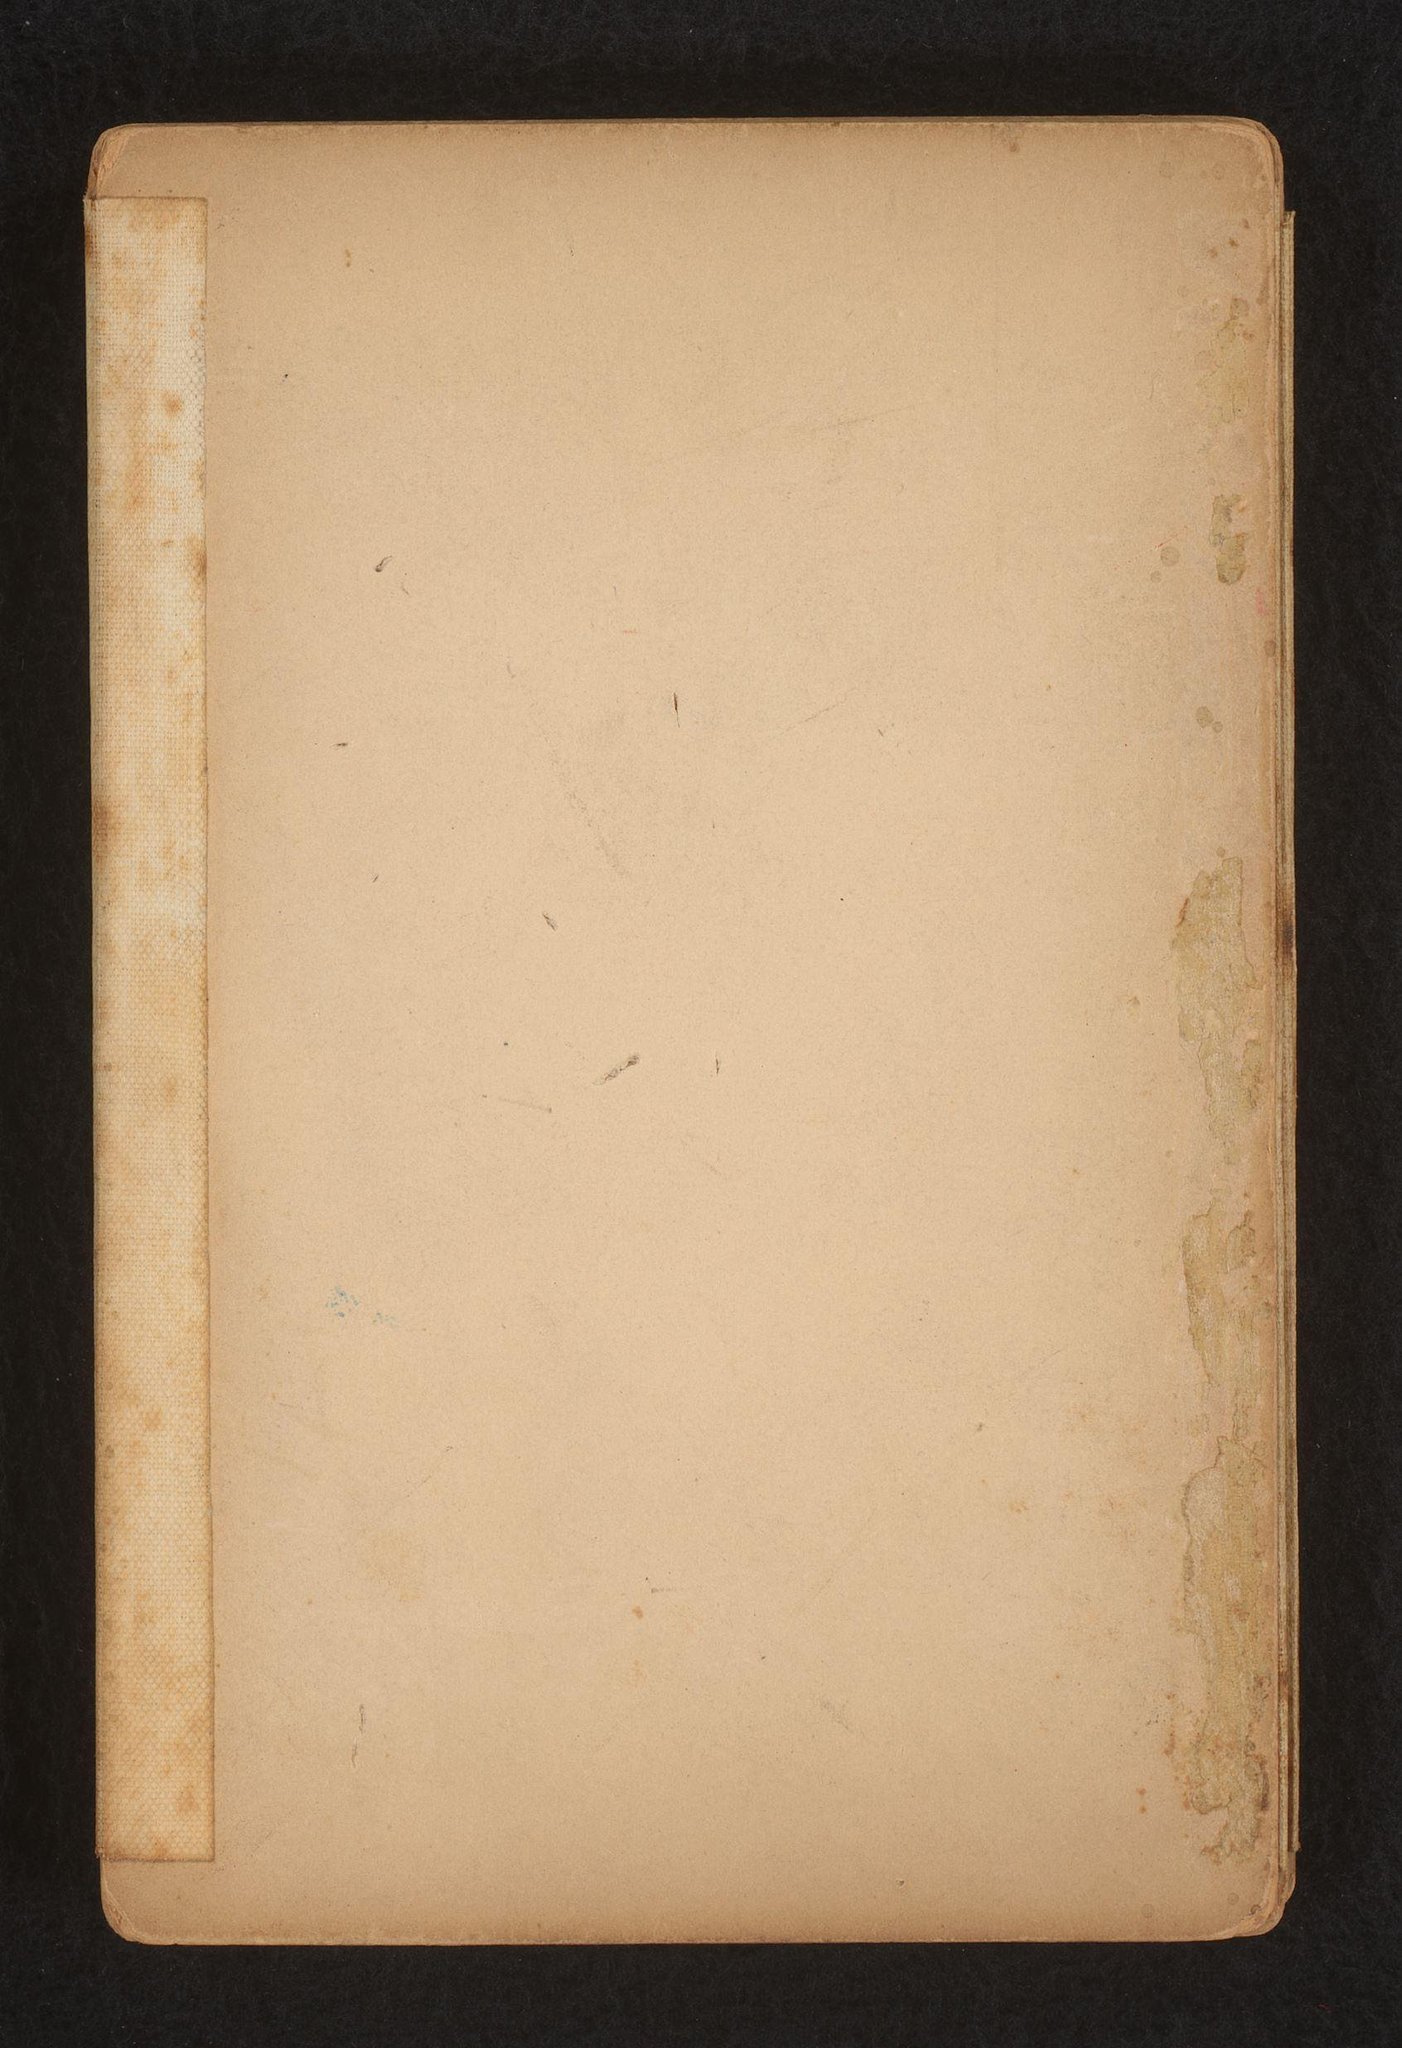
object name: photograph album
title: Leporelloalbum met acht foto's van Amsterdam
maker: andries jager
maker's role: publisher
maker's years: 1825-1905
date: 1870-1890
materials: cardboard, paper, photographic support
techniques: albumen print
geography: amsterdam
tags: city-view in general; 'veduta', amsterdam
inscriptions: collector's mark: ‘Dienst Verspreide Rijkskollekties (...) A919’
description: Leporelloalbum zonder band met acht stadsgezichten van Amsterdam. Het album bevat acht aan elkaar vastzittende, kartonnen bladen met foto's. De bladen zijn als een harmonica uitklapbaar. Onder andere te zien zijn het Rijksmuseum, de Beurs en de Oudeschans.